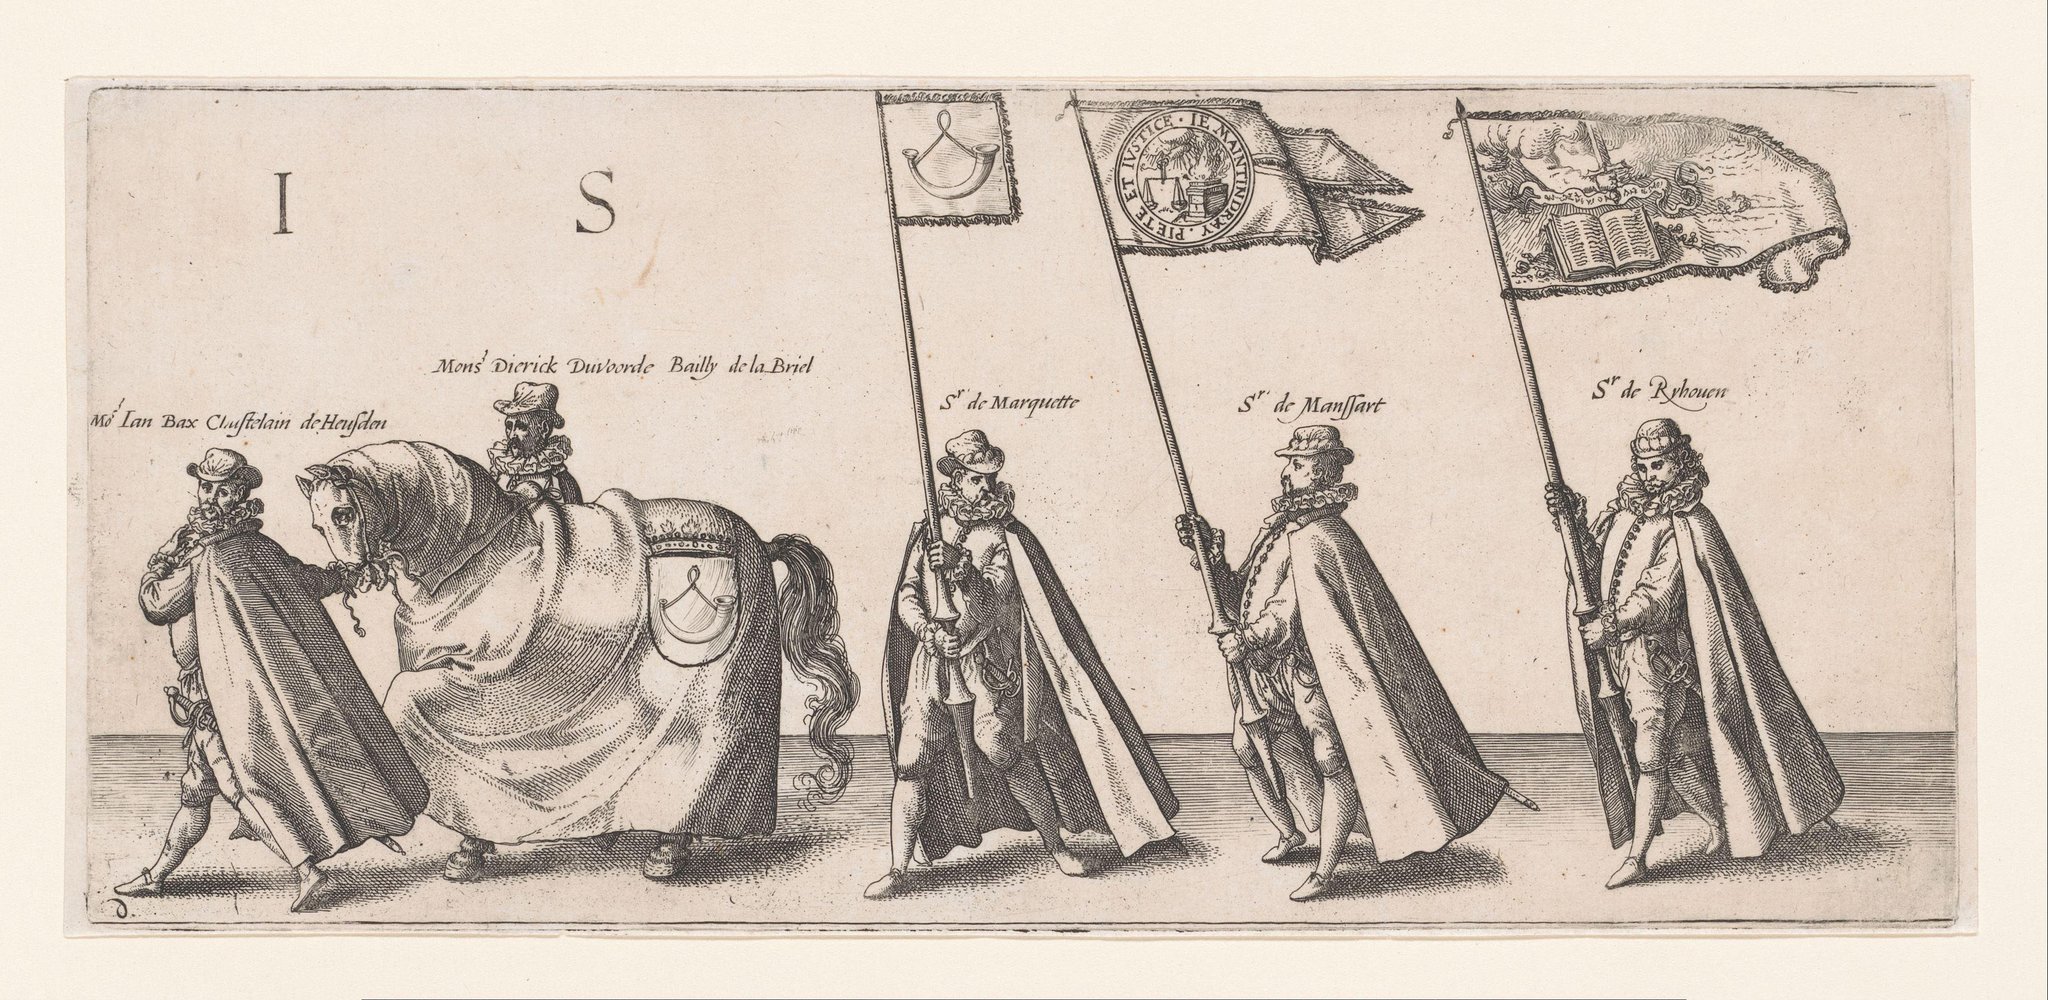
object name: print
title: Begrafenisstoet van Willem van Oranje, blad 6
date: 1584-1638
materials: paper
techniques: engraving, etching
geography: amsterdam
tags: delft, william i (prince of orange), cortege, funeral procession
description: Lijkstatie met de heren Jan Bax van Heusden, Dierick Duvoorde, baljuw van Den Briel, van Marquette, van Manssaert en Van Ryhoven met een paard met het wapen en vaandel van Oranje, een vaandel met de hand van God met weegschaal en spreuk: Je maintindray Piete et Justice en een vaandel met de hand van God met zwaard en bijbel. Blad 6 in de begrafenisstoet van Willem van Oranje, Delft 3 augustus 1584.